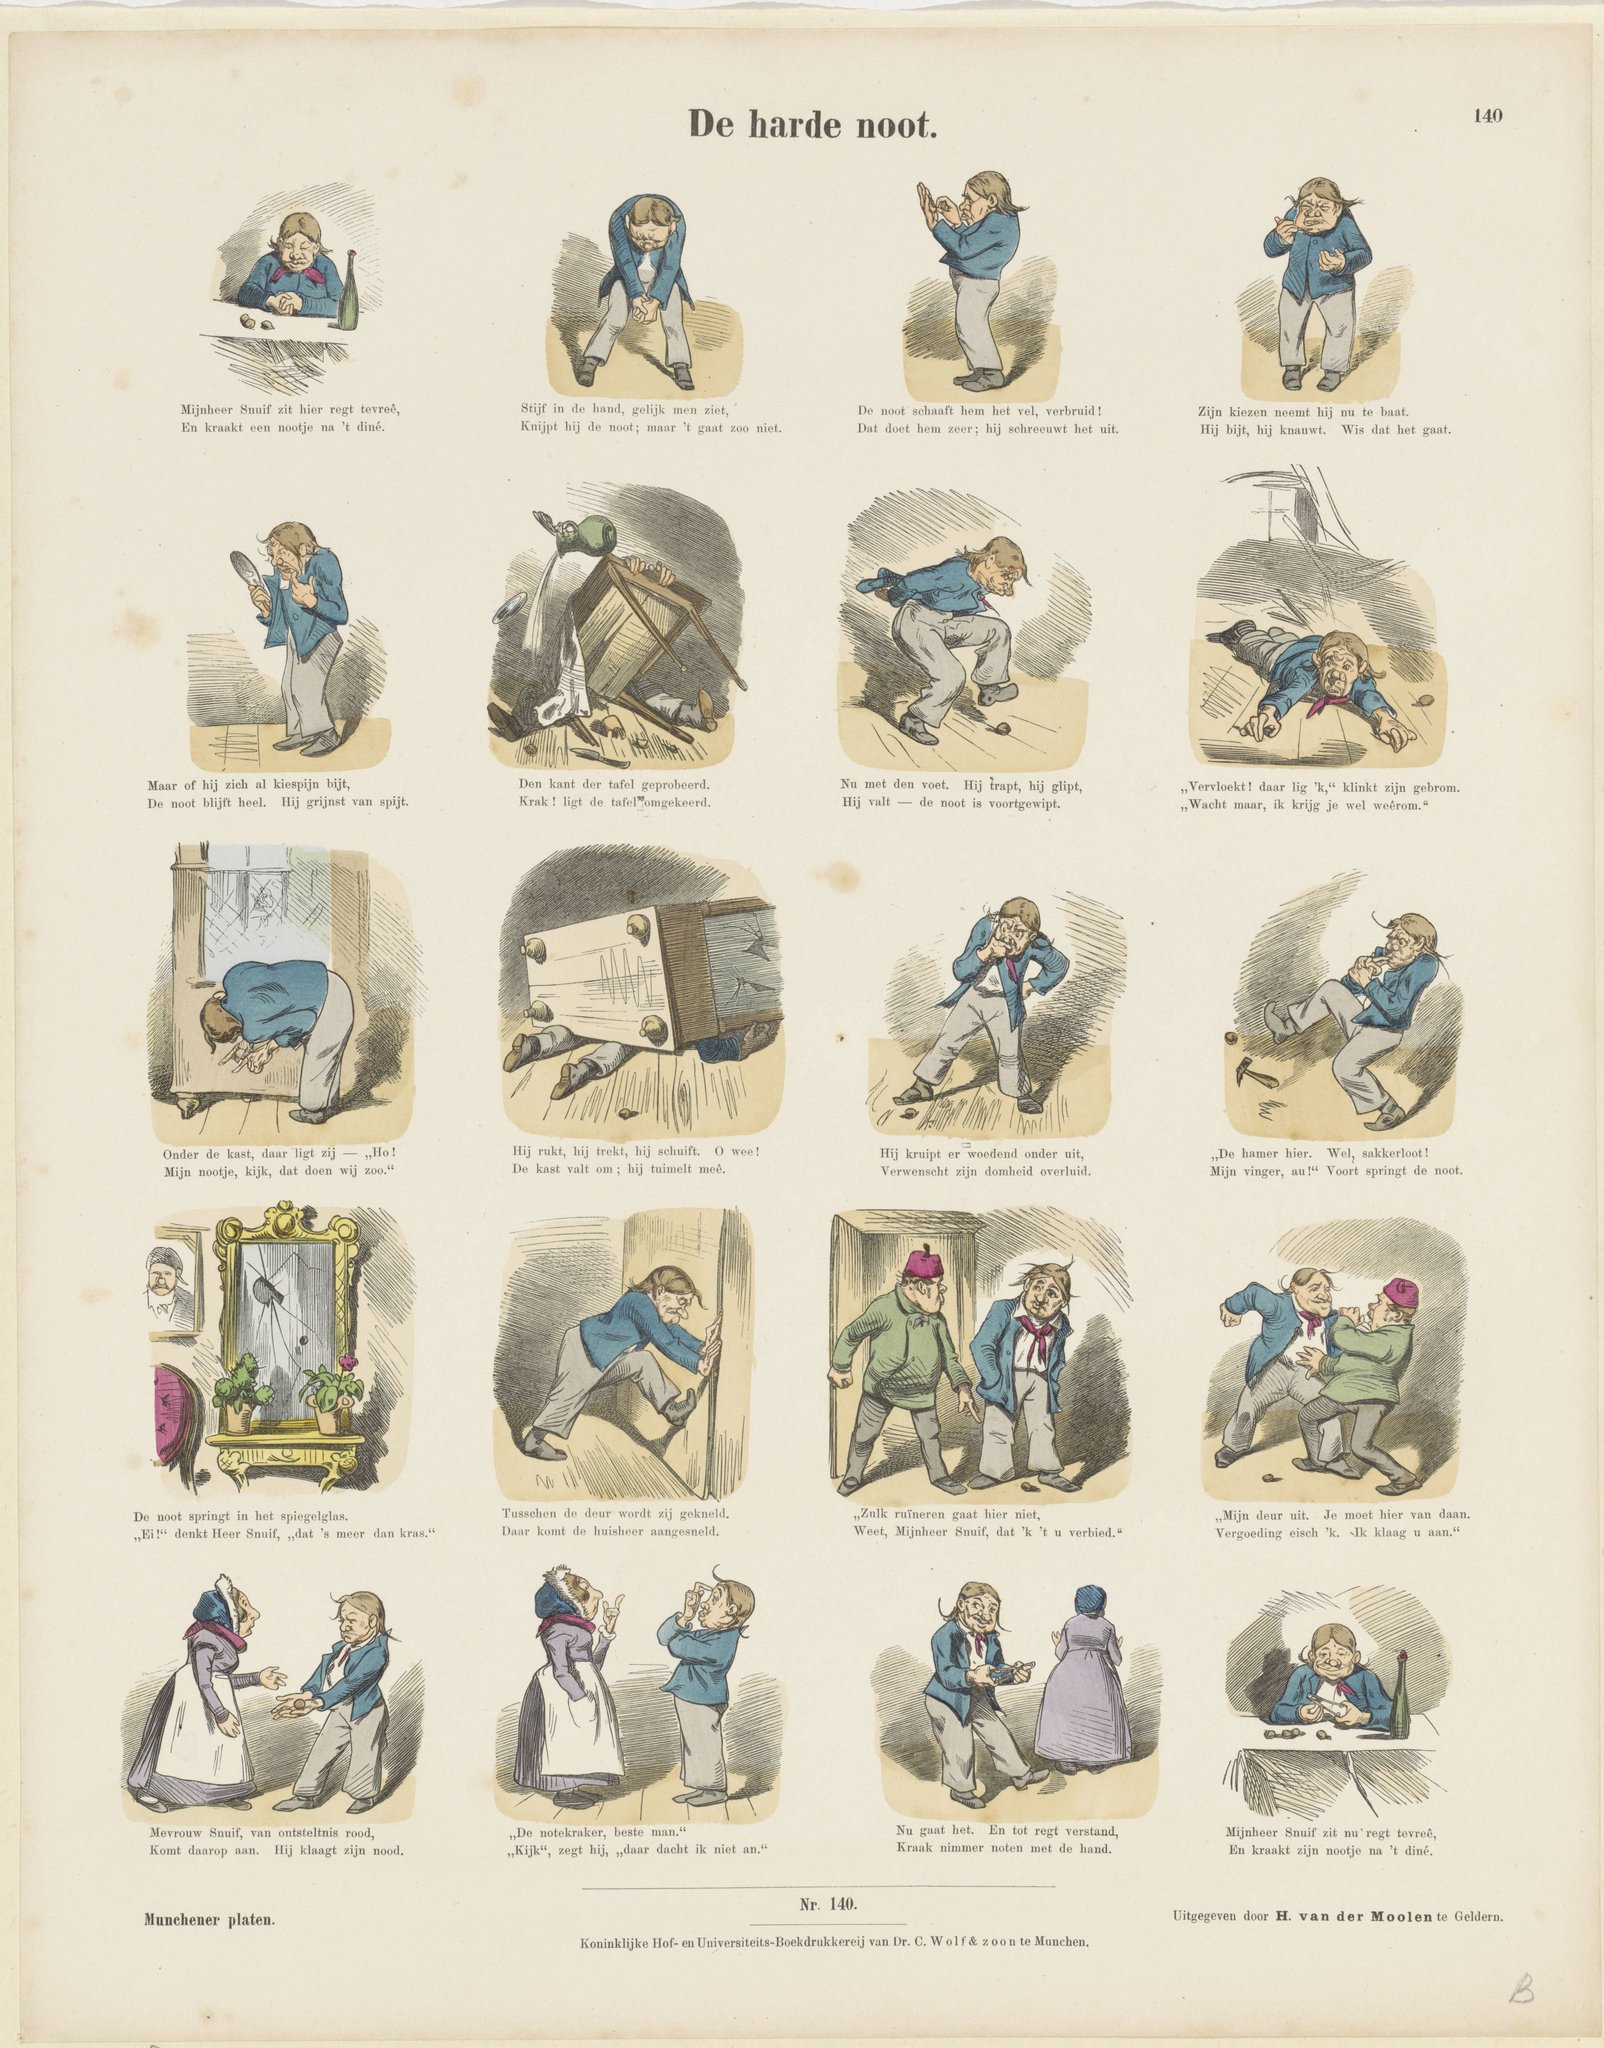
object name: print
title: De harde noot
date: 1843-1920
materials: paper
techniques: colour, letterpress printing, engraving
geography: germany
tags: fruits: walnut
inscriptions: collector's mark: Lugt 2760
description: Blad met 20 voorstellingen over een man die na veel vergeefse pogingen toch een noot weet te kraken. Onder elke afbeelding een tweeregelig vers. Genummerd midden onder: Nro. 140. Genummerd rechtsboven: 140.